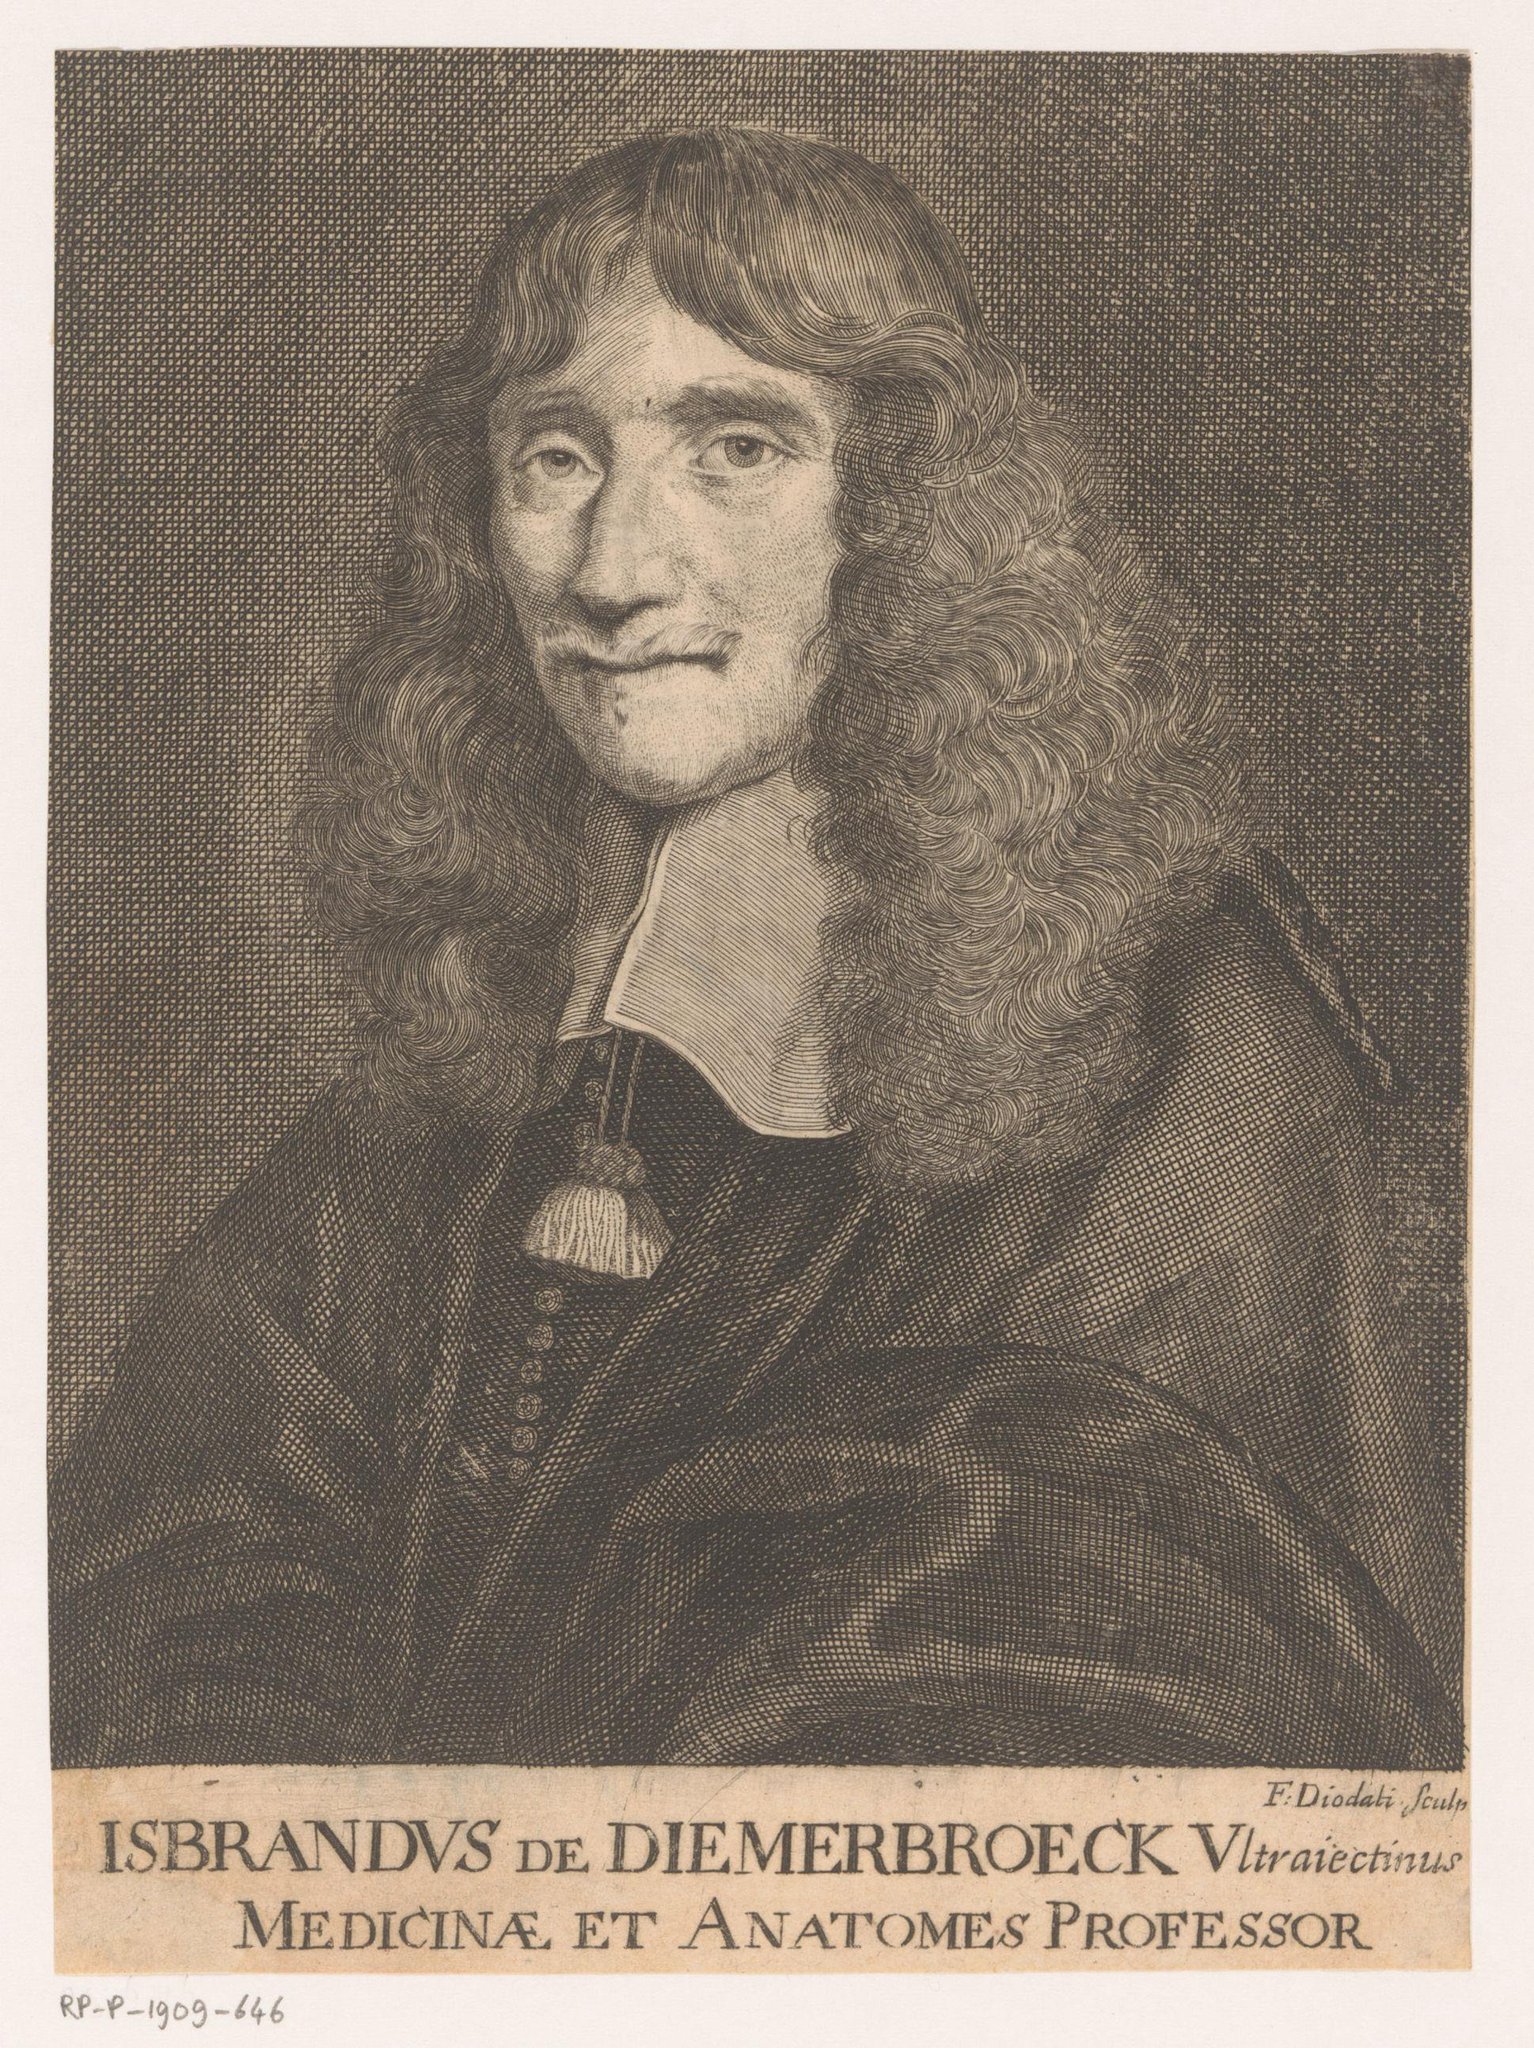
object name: print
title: Portret van IJsbrand van Diemerbroeck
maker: françois diodati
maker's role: print maker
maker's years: 1647-1690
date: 1657-1690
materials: paper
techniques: engraving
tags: utrecht, historical persons, physician, doctor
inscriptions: collector's mark: Lugt 2228